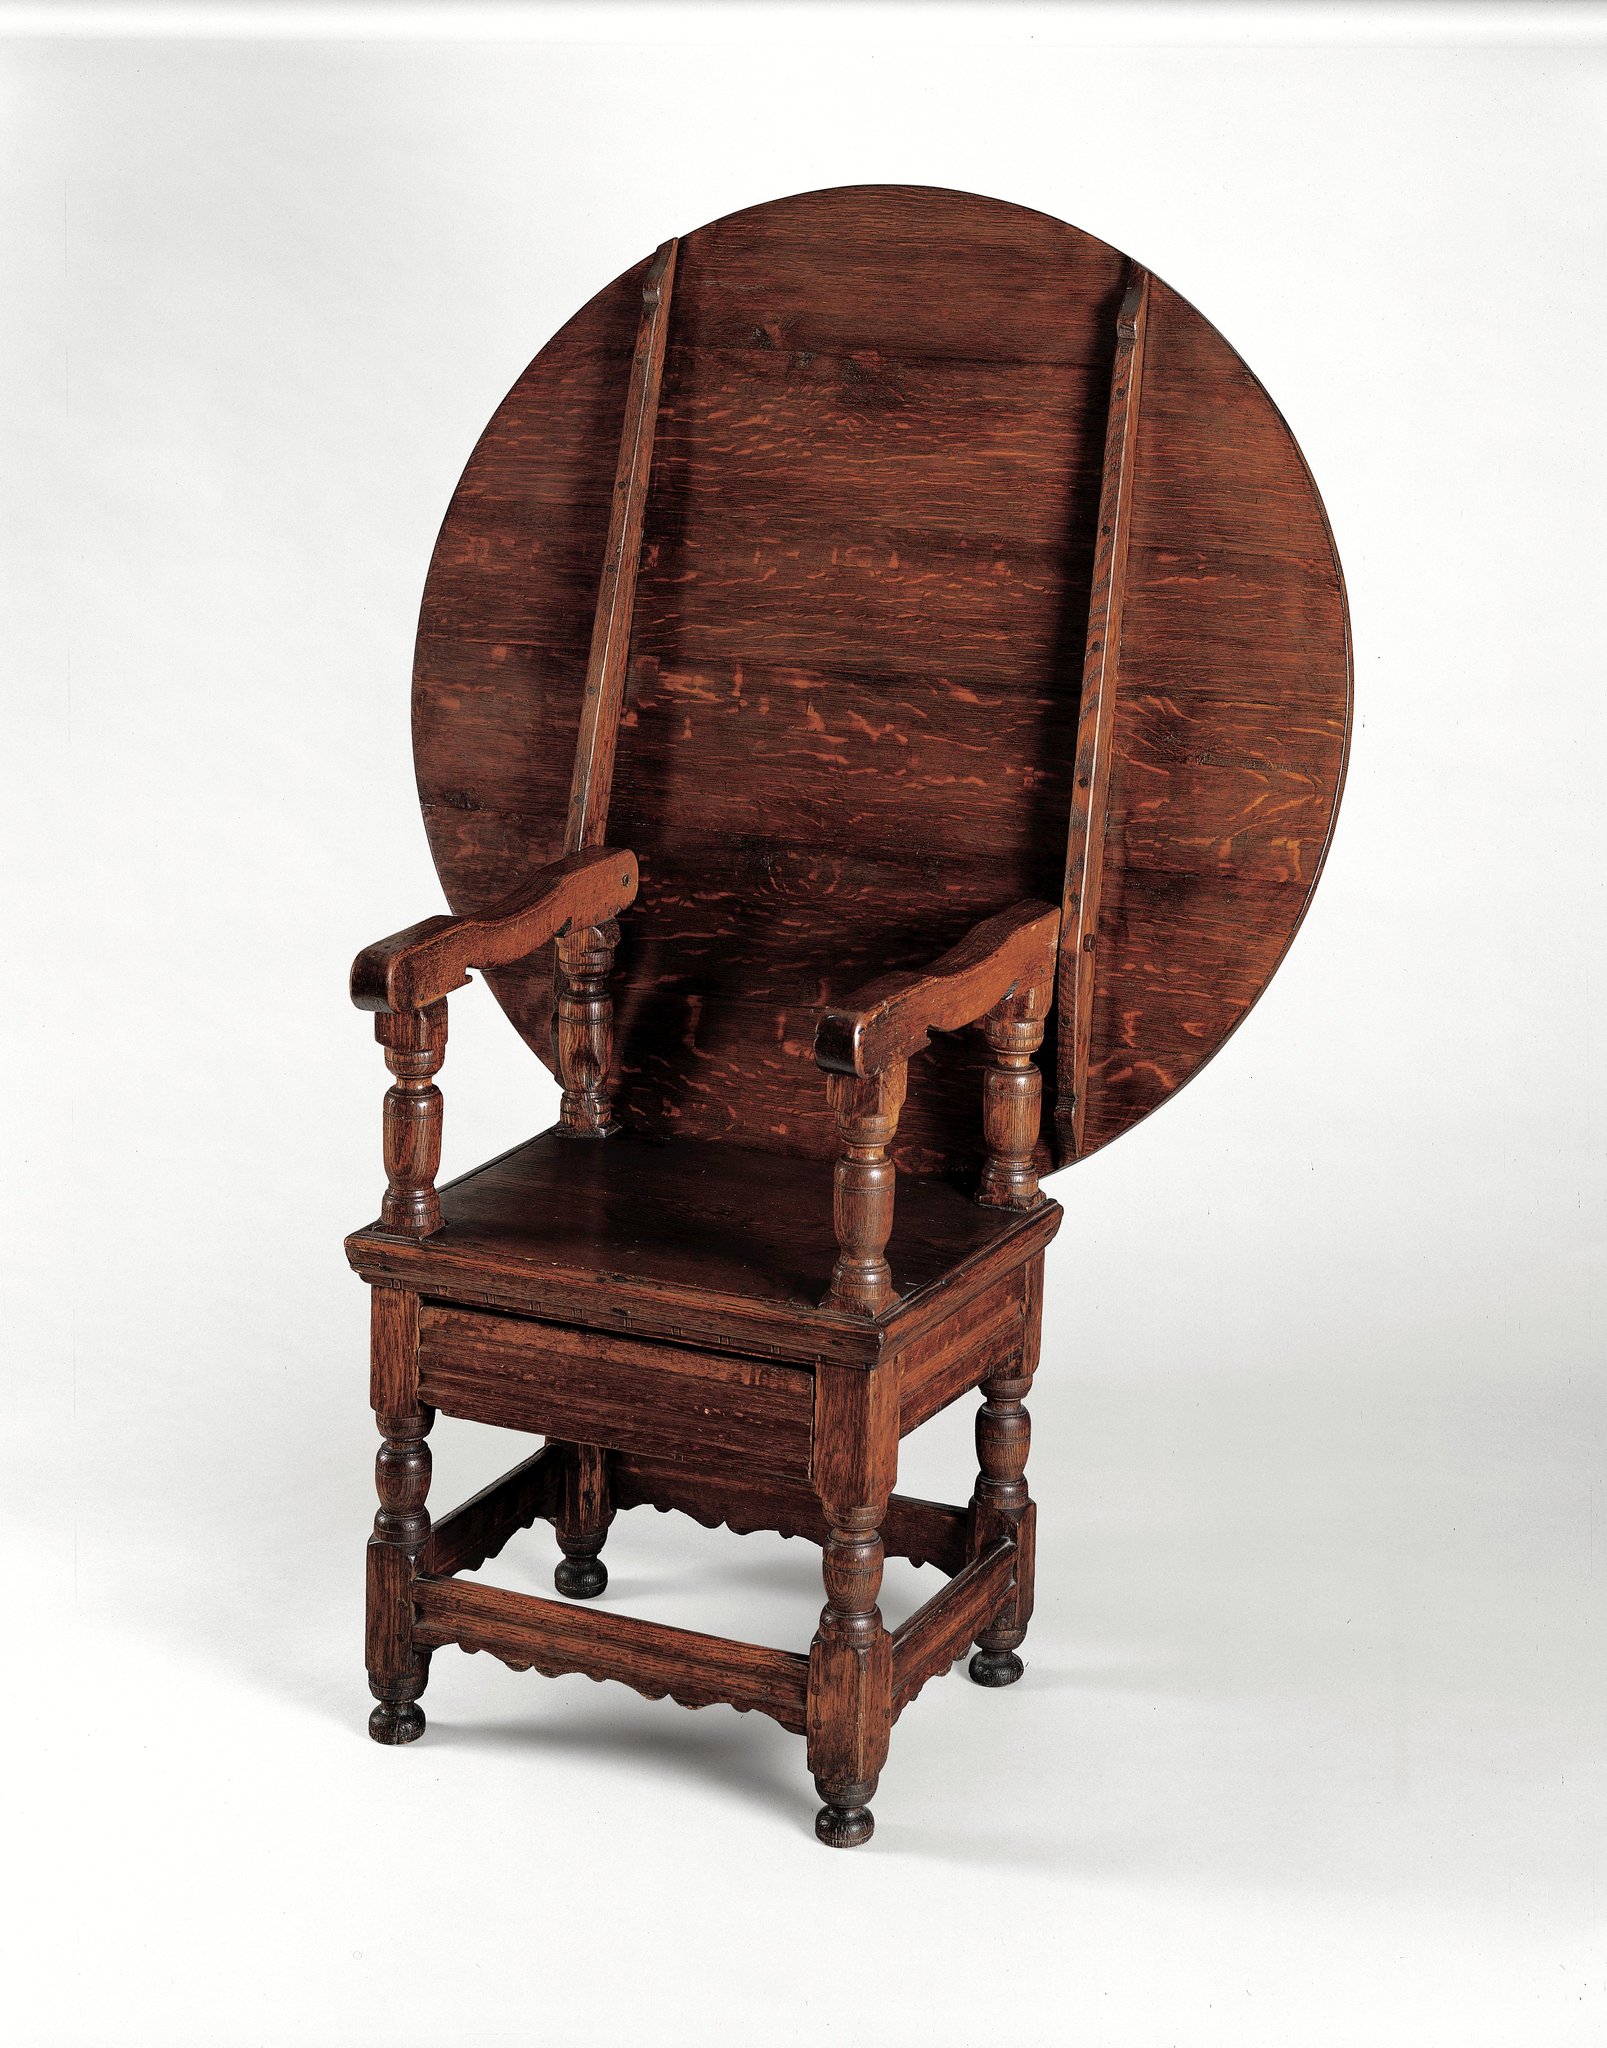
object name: chair table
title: Chair-table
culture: american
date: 1650-1700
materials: wood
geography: united states